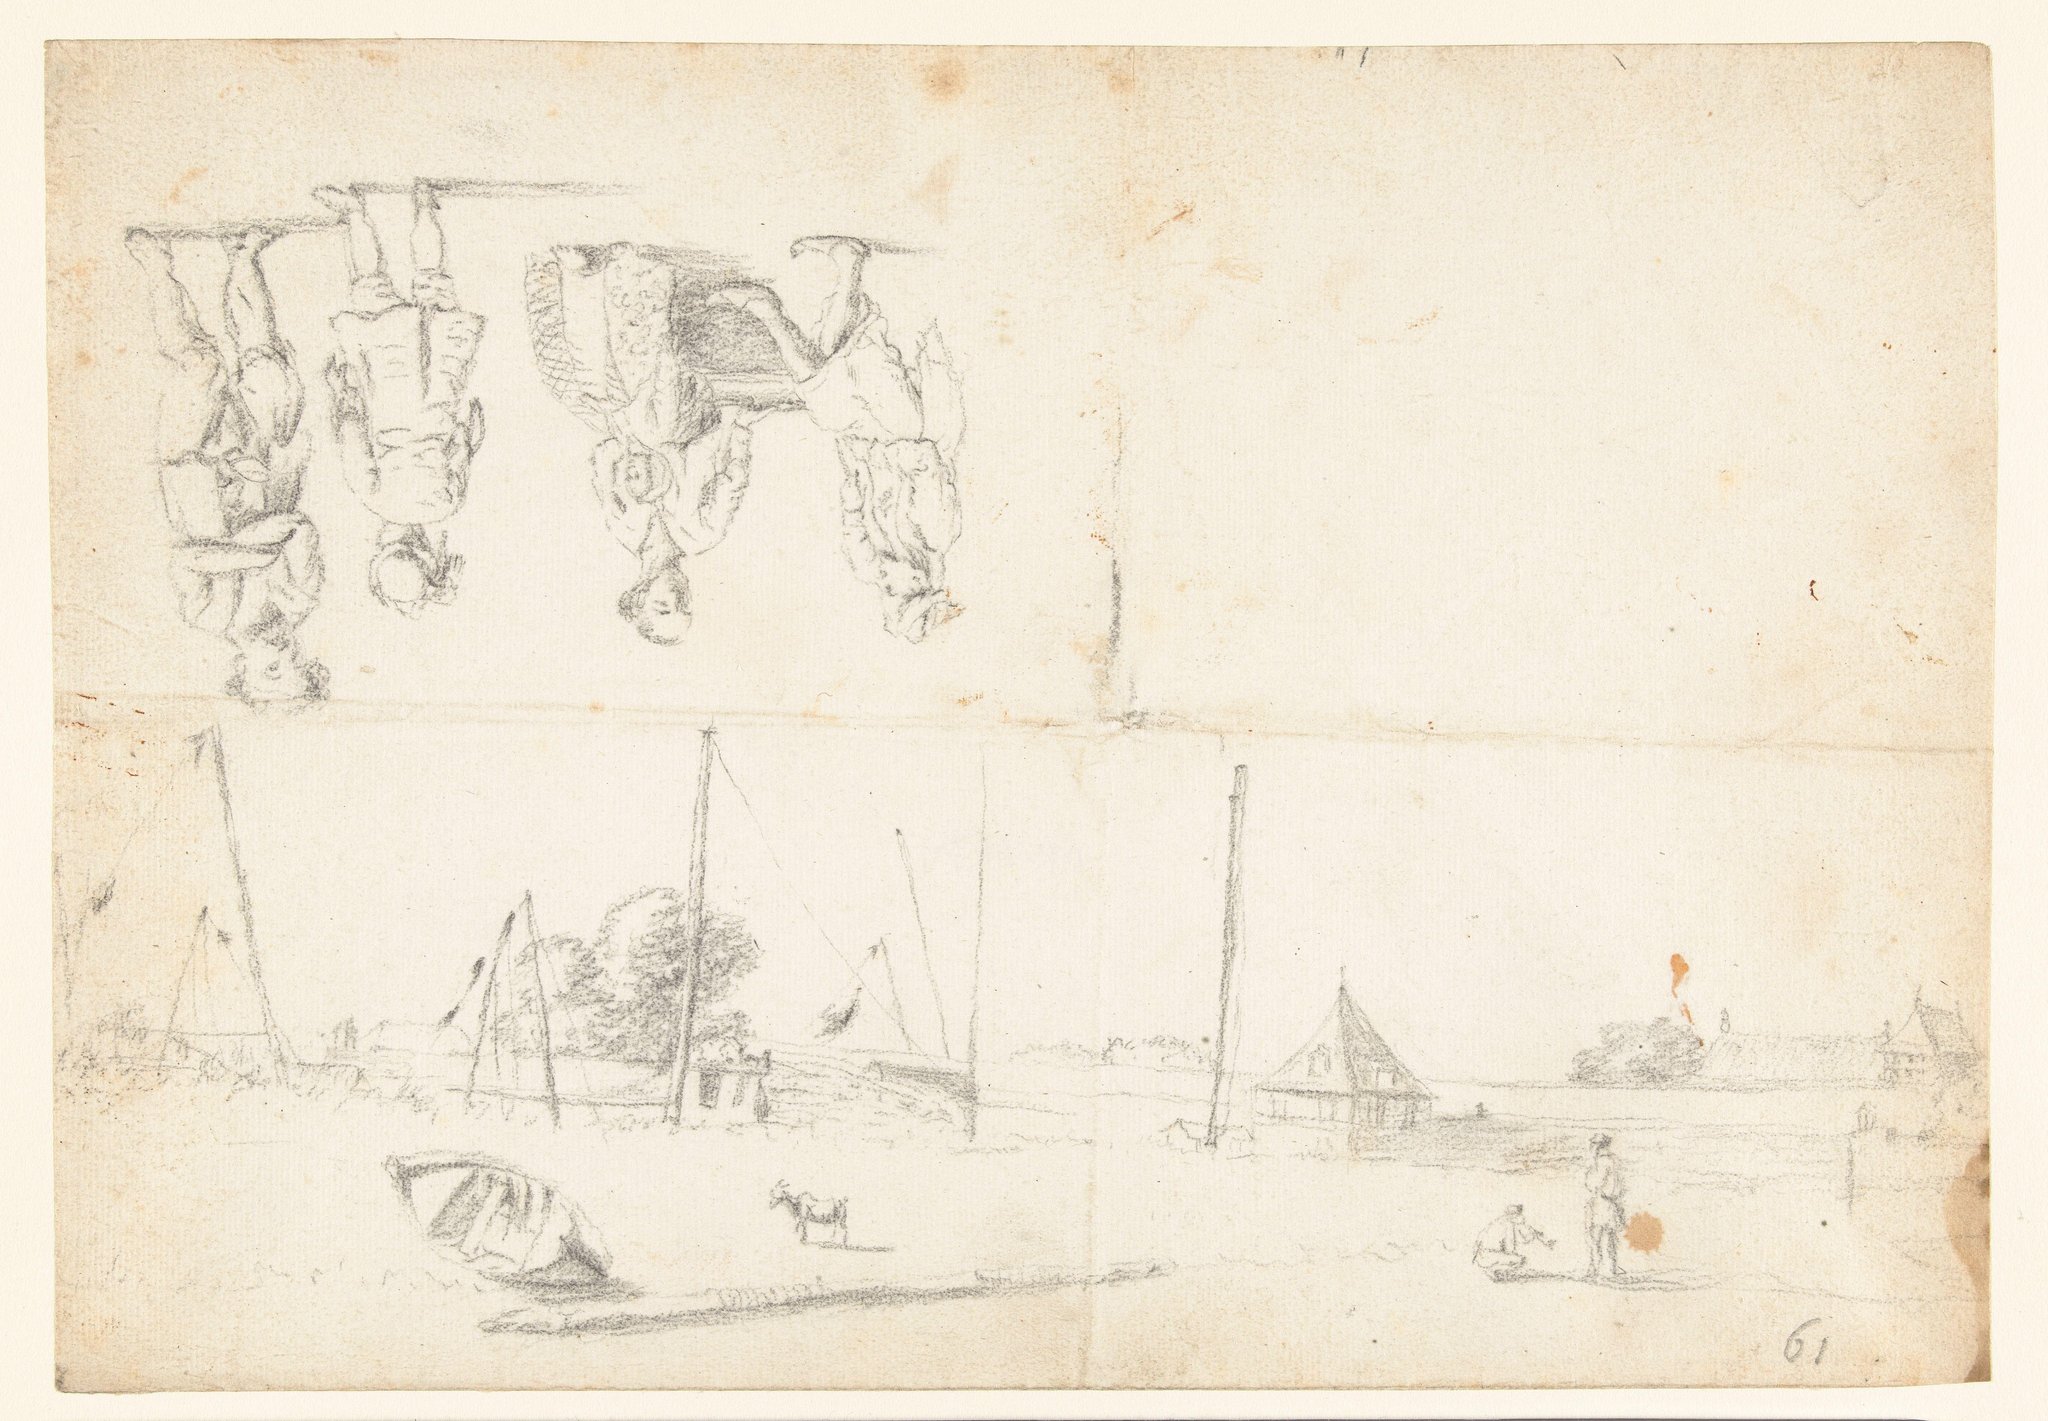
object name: drawing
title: Schetsblad met vaartgezicht en figuren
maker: wouter schouten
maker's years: 1638-1704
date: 1660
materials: chalk, paper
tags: indië